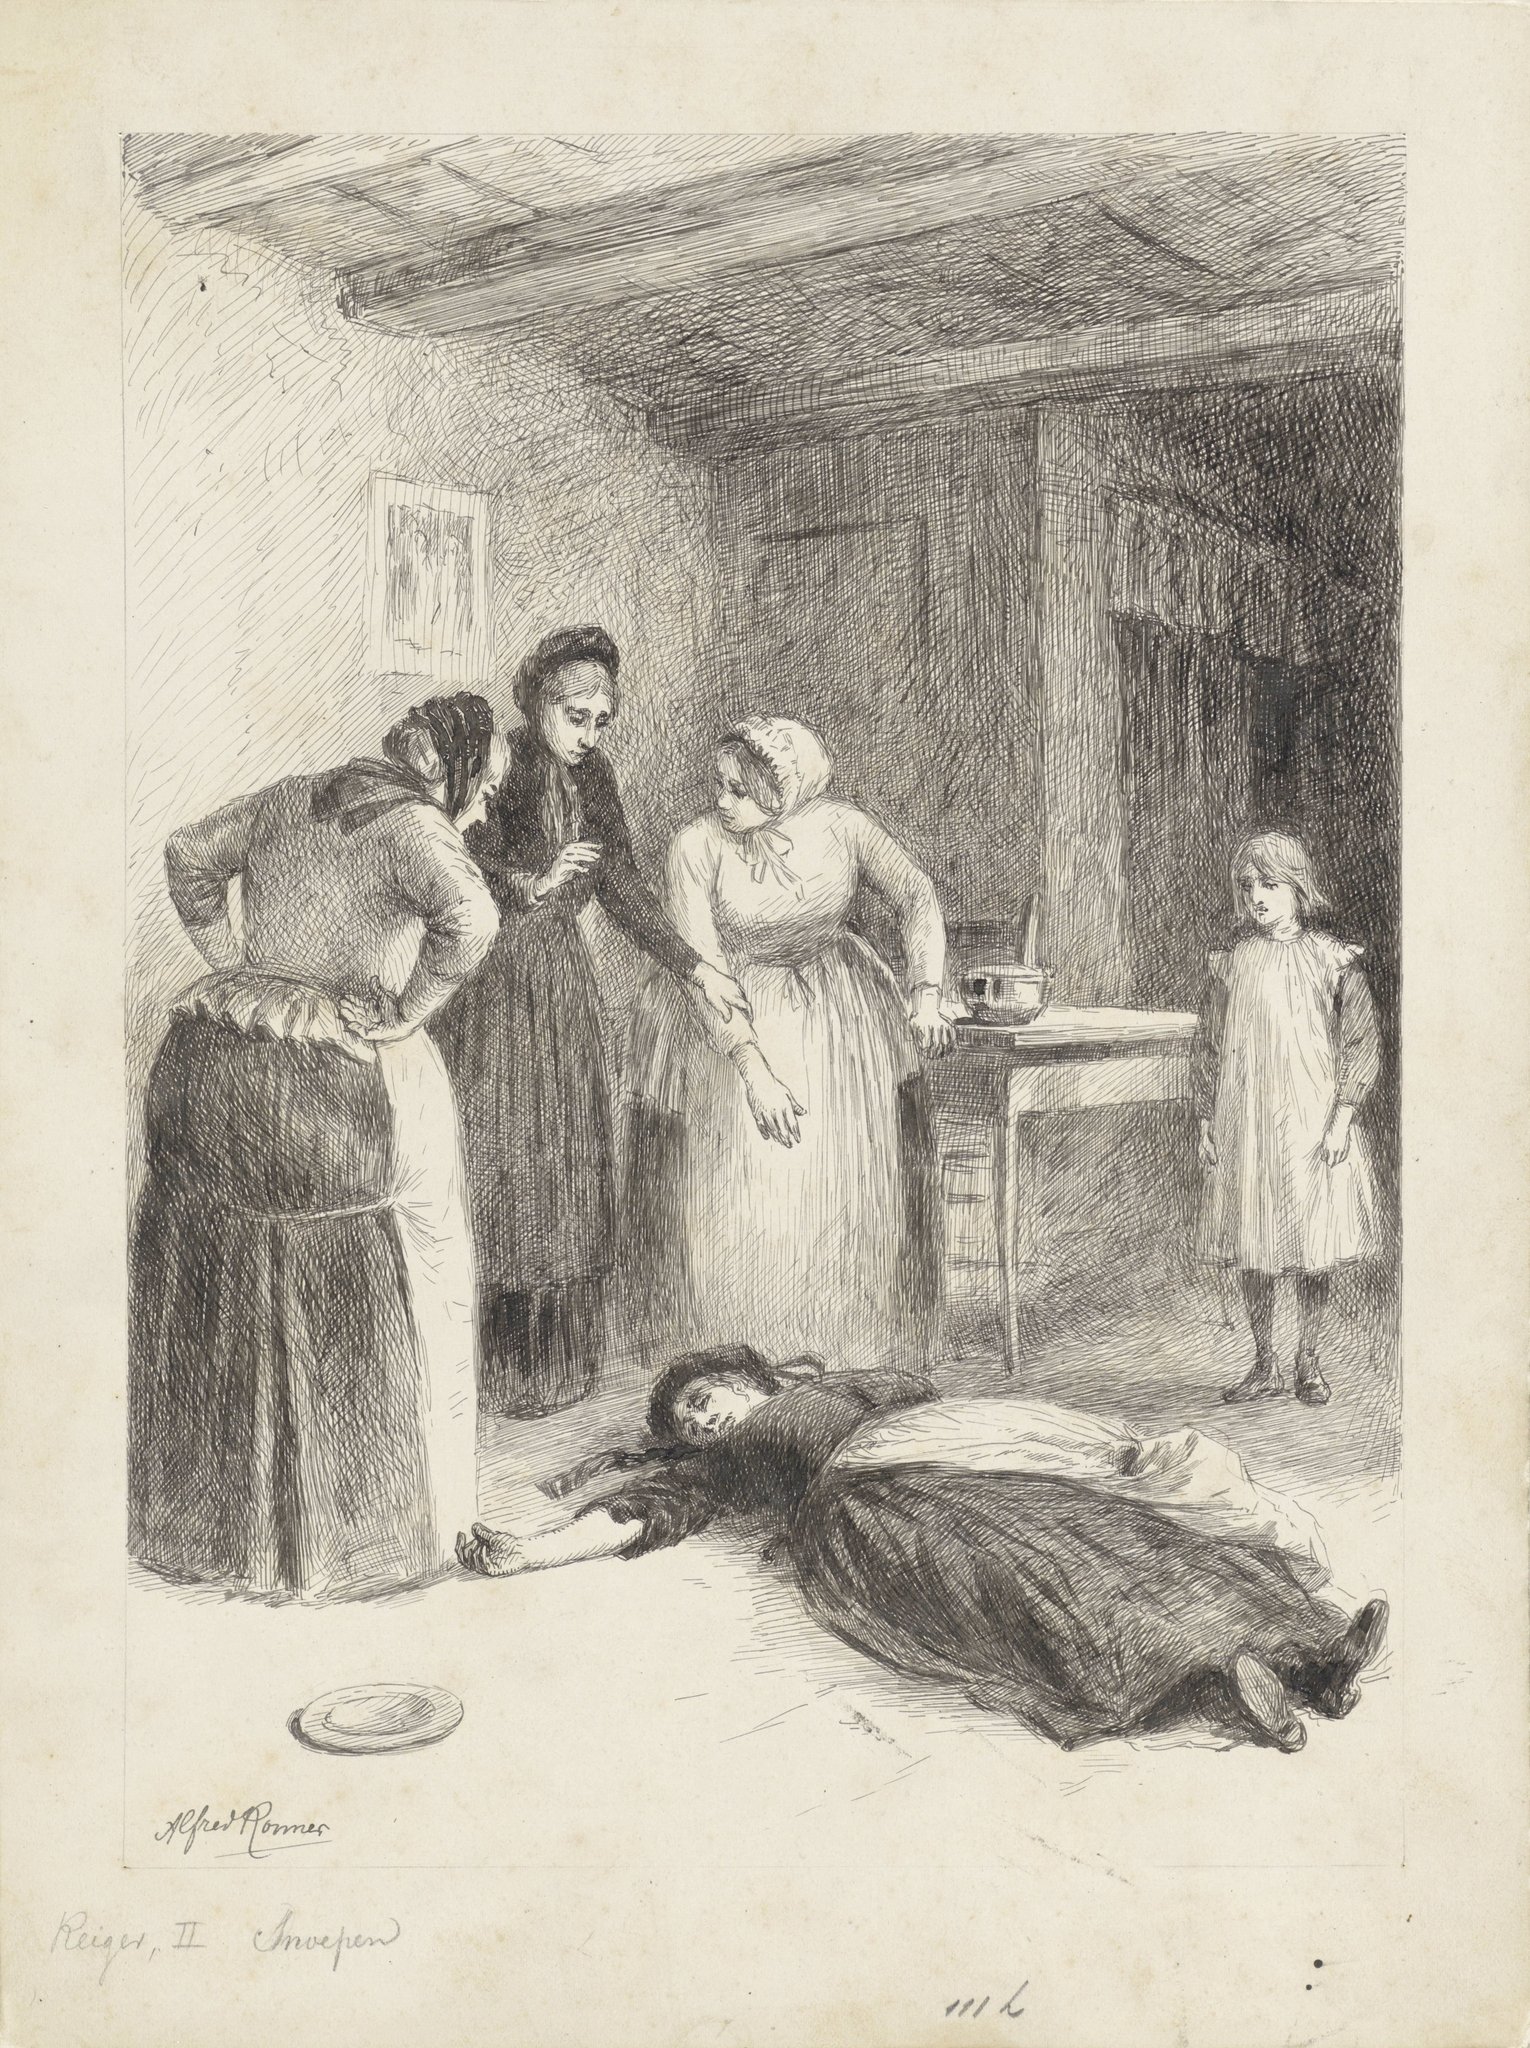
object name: drawing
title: Snoepen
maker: alfred ronner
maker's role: draughtsman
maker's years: 1852-1901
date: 1893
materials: ink, paper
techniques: pen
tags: (reiger, a.f.j., vluchtige schetsen uit het volksleven) specific works of literature (with author, title)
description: Illustratie voor 'Vluchtige Schetsen uit het Volksleven' door A.F.J. Reiger. Ontwerp voor een prent.